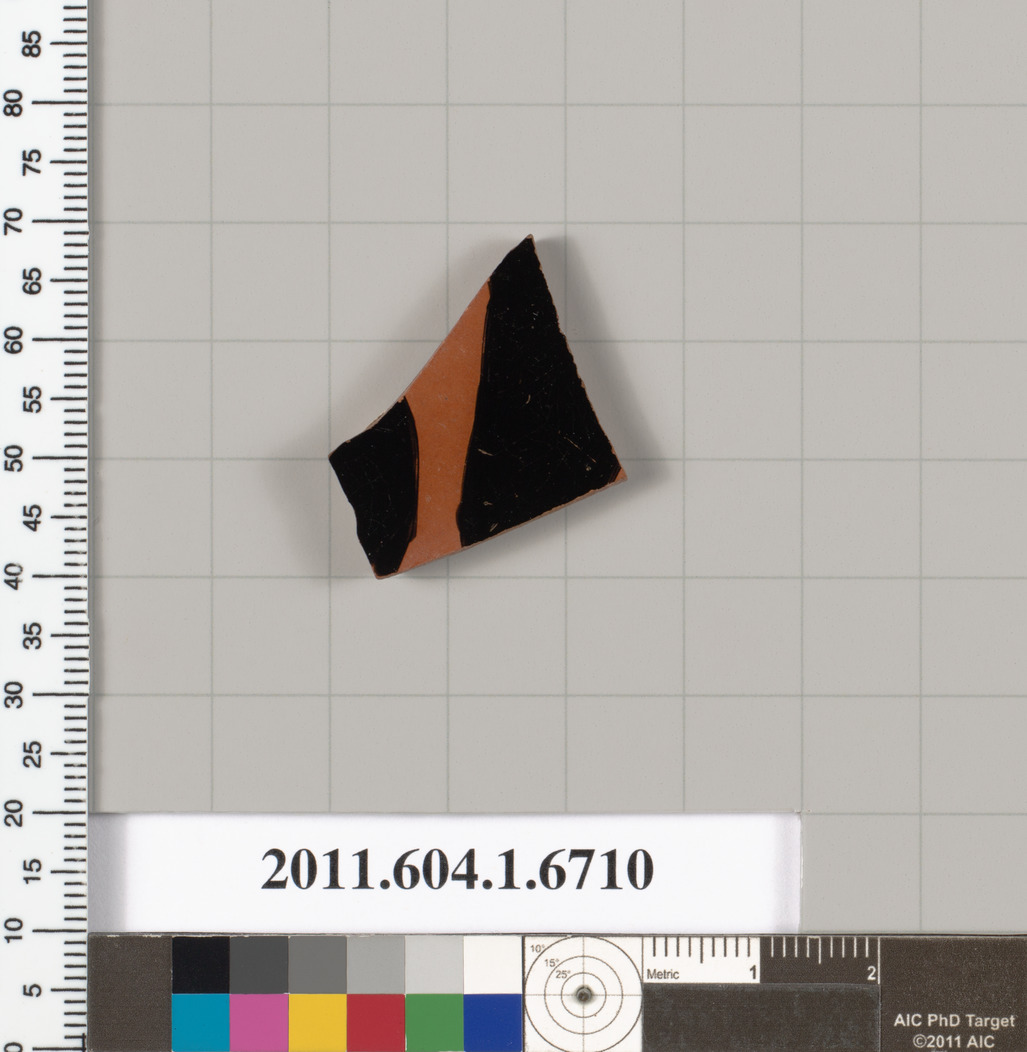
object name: kylix fragment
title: Terracotta fragment of a kylix (drinking cup)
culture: greek, attic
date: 490-470 BCE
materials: terracotta